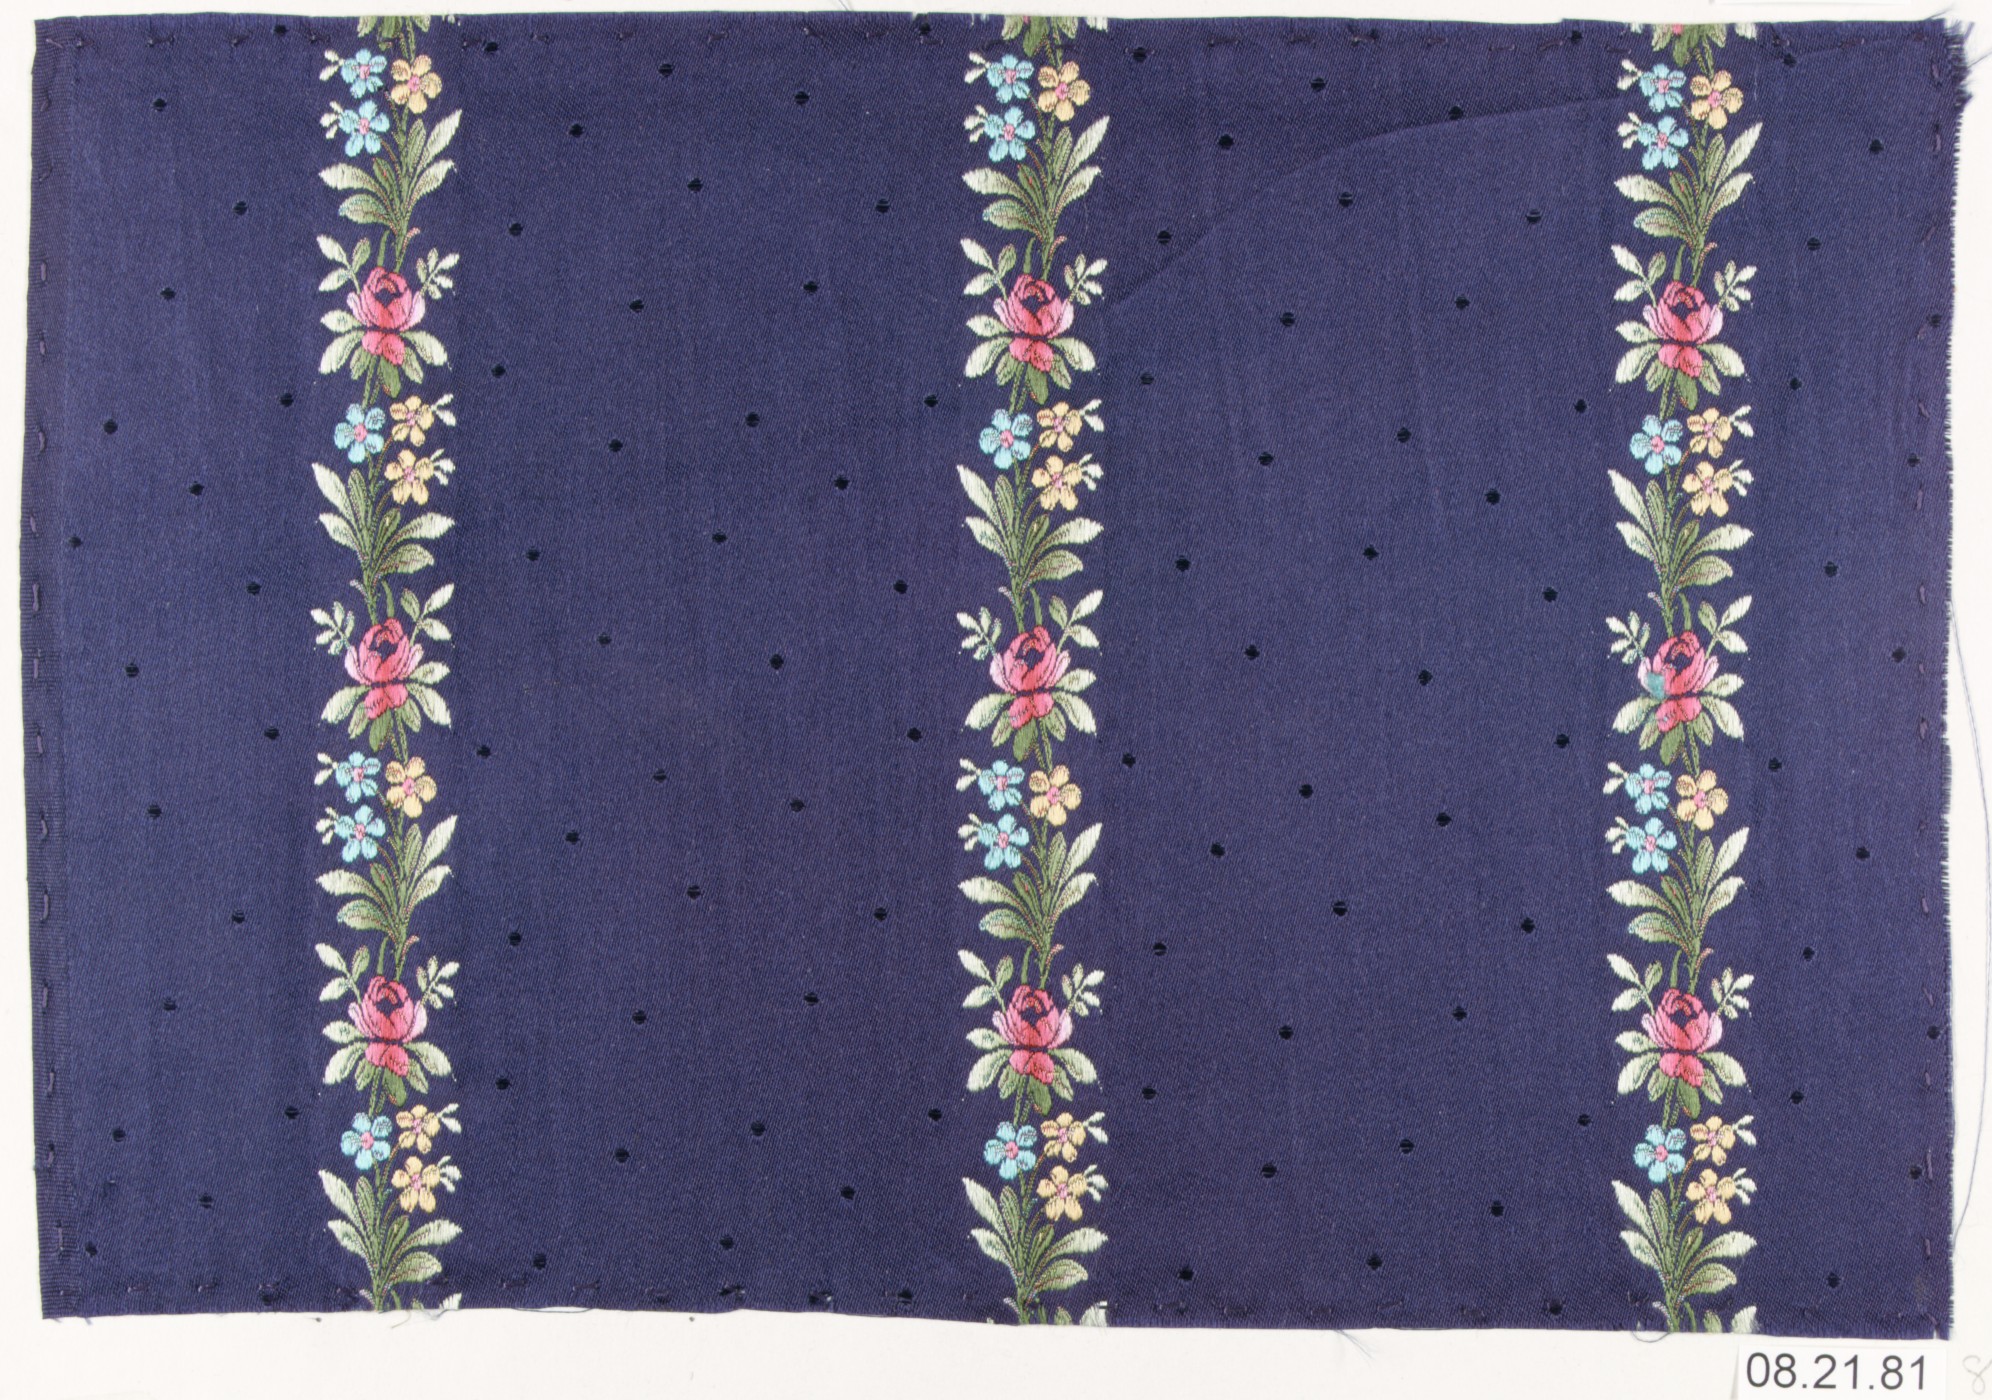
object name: textile sample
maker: Anonymous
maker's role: designer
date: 1900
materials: silk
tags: flowers